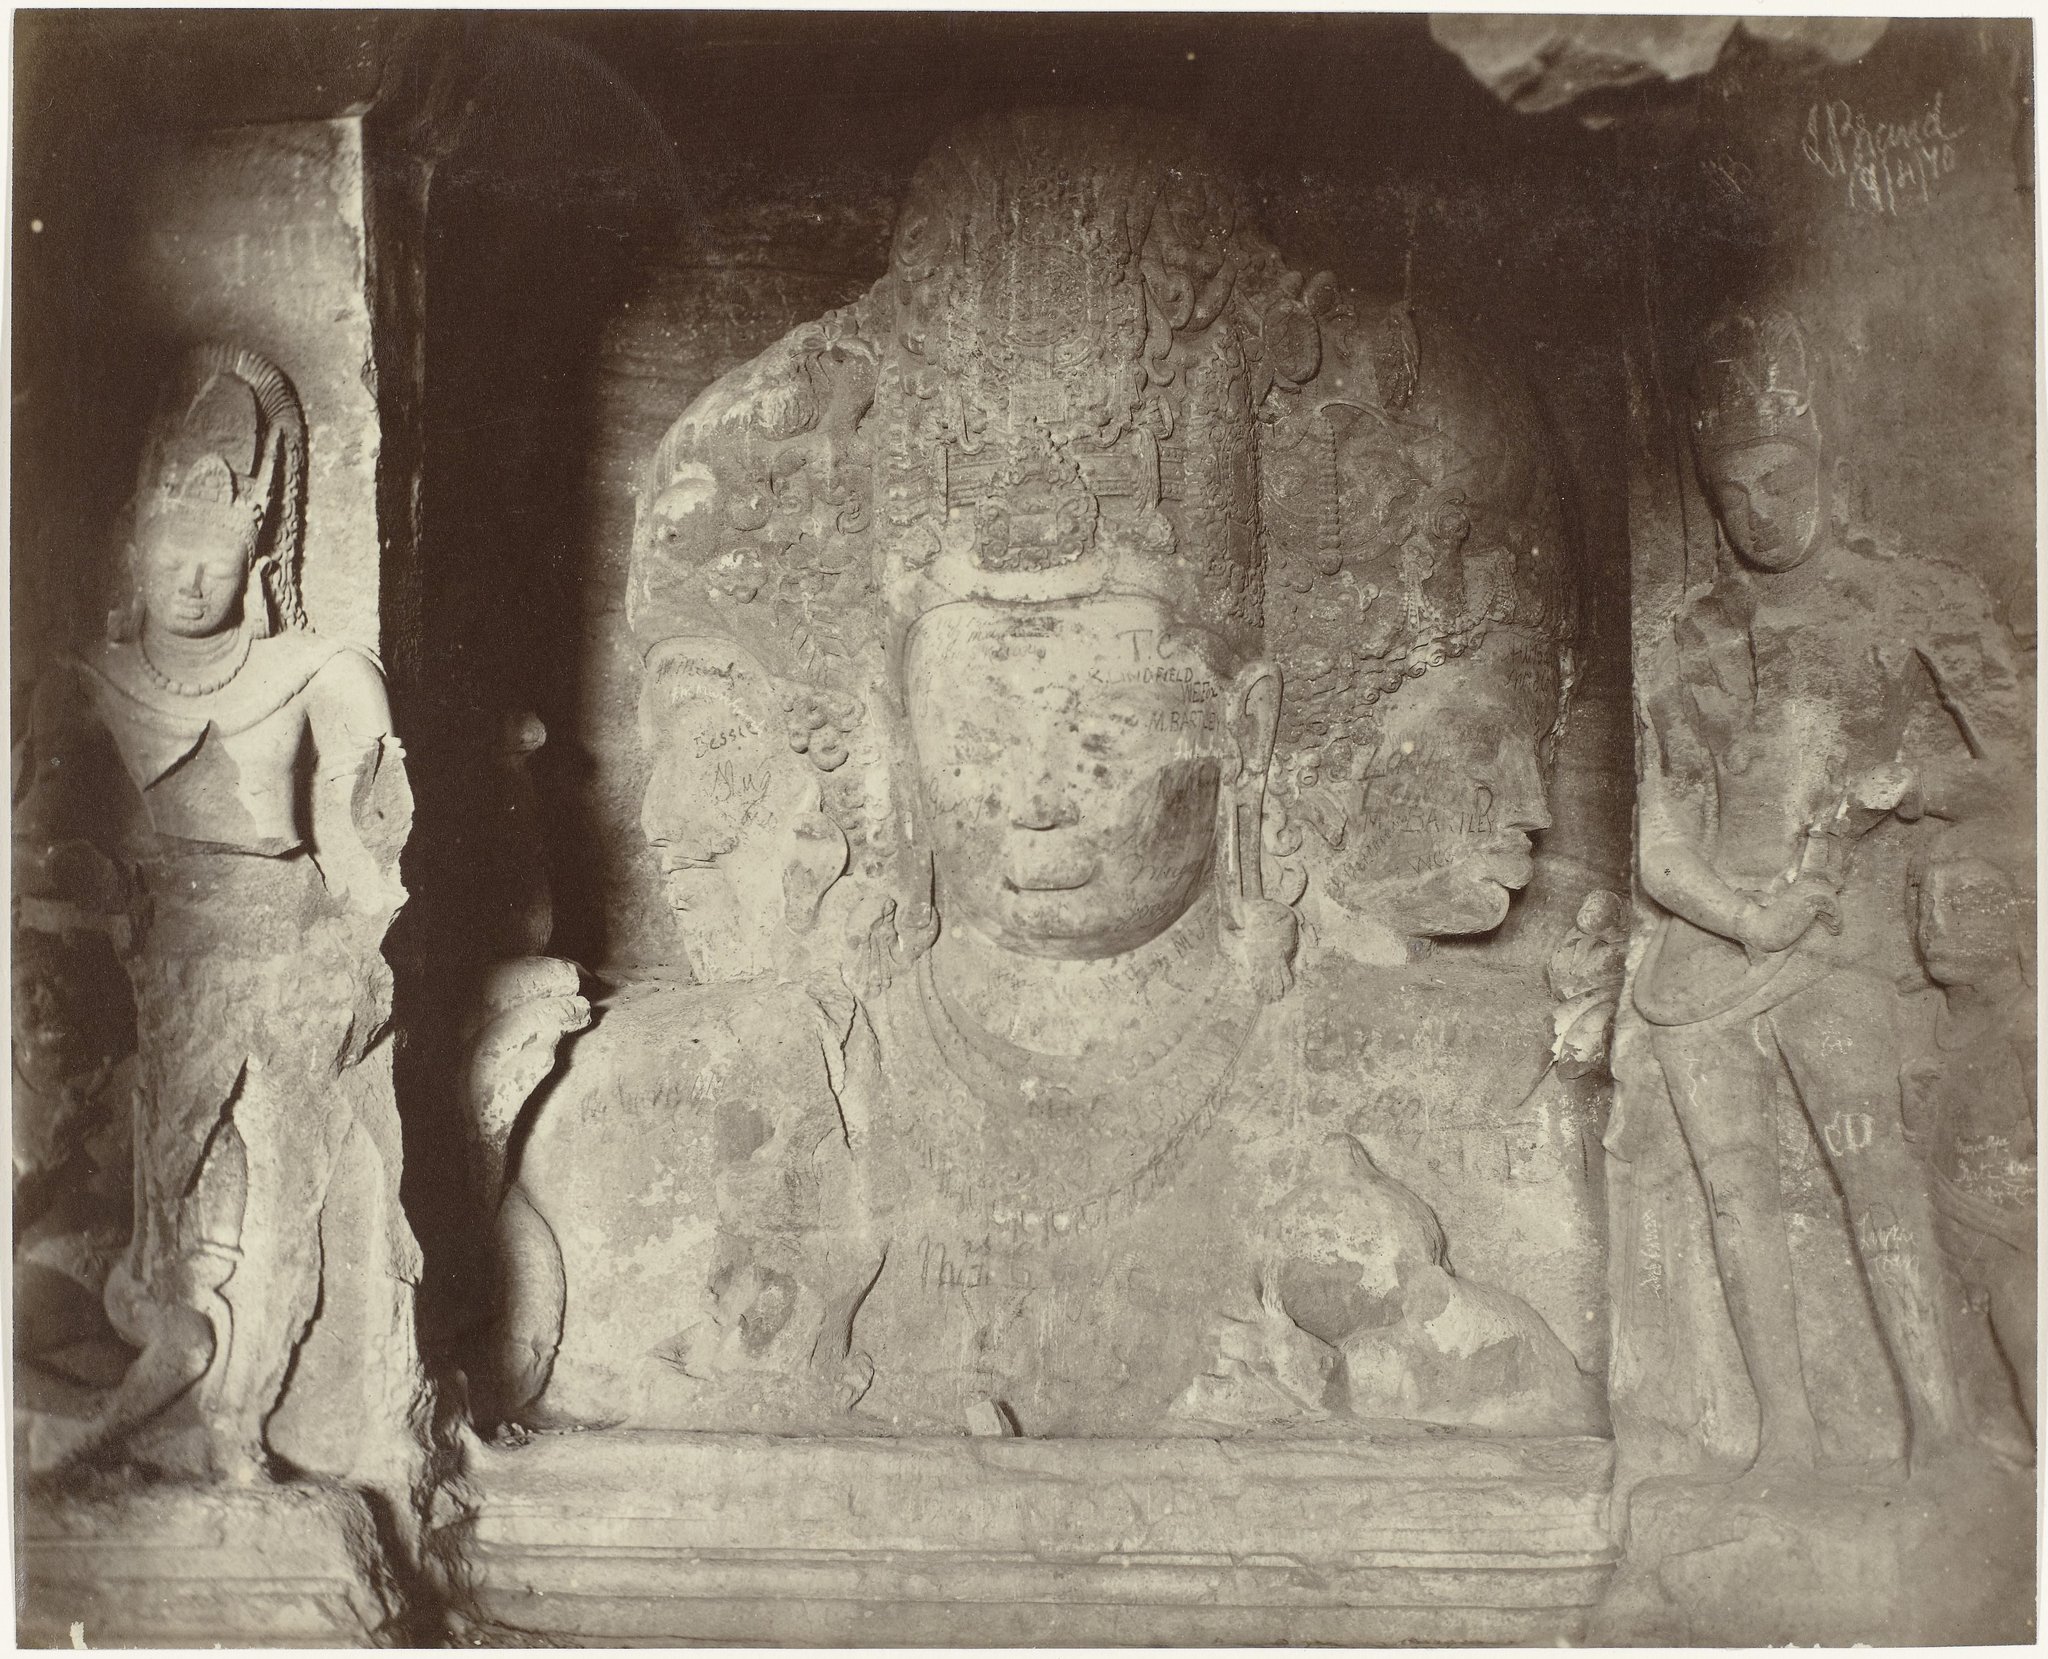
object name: photograph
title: Relief with Sadashiva in the Elephanta Caves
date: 1869-1870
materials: cardboard, paper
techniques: albumen print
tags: shiva, temple, shrine ~ hinduism, buddhism, jainism, art (+ relief ~ sculpture), representations ~ gods, demi-gods, heroes, etc. (hinduism, buddhism, jainism)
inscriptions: number: ‘2194’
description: This relief is located at the entrance to the Elephanta Caves near Mumbai. The caves form a collection of temples dedicated primarily to the Hindu god Shiva. The relief shows Shiva in three incarnations. On the left, the Aghora who wards off negative energy with anger. On the right, Vamadeva, elegance. In the middle, Tatpurusha, in contemplation. Together they represent balance, the core of the ancient Indian yoga doctrine.